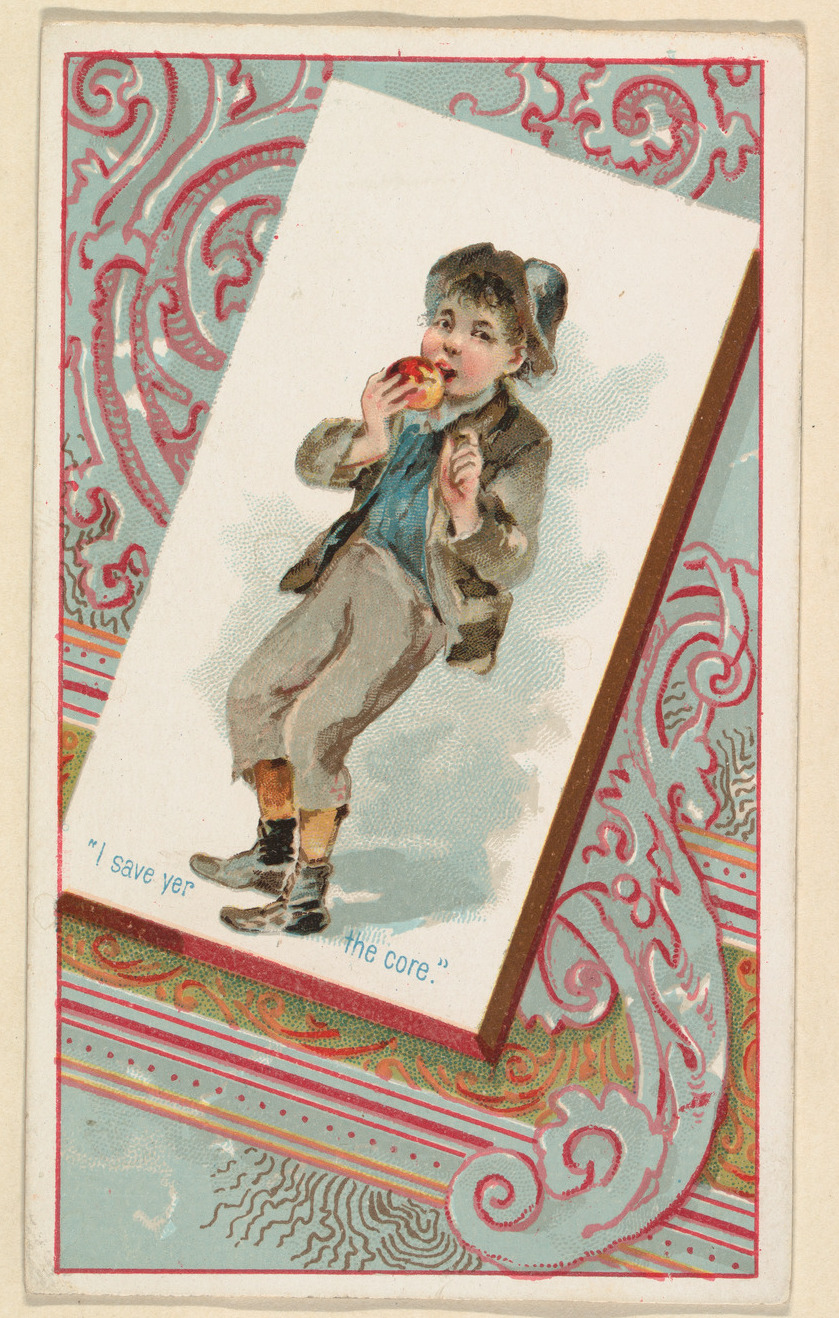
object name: print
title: "I save yer the core," from the Terrors of America set (N136) issued by Duke Sons & Co. to promote Honest Long Cut Tobacco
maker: w. duke, sons & co.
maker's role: publisher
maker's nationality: american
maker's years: 1870-1920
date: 1888-1889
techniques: color lithograph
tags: boys